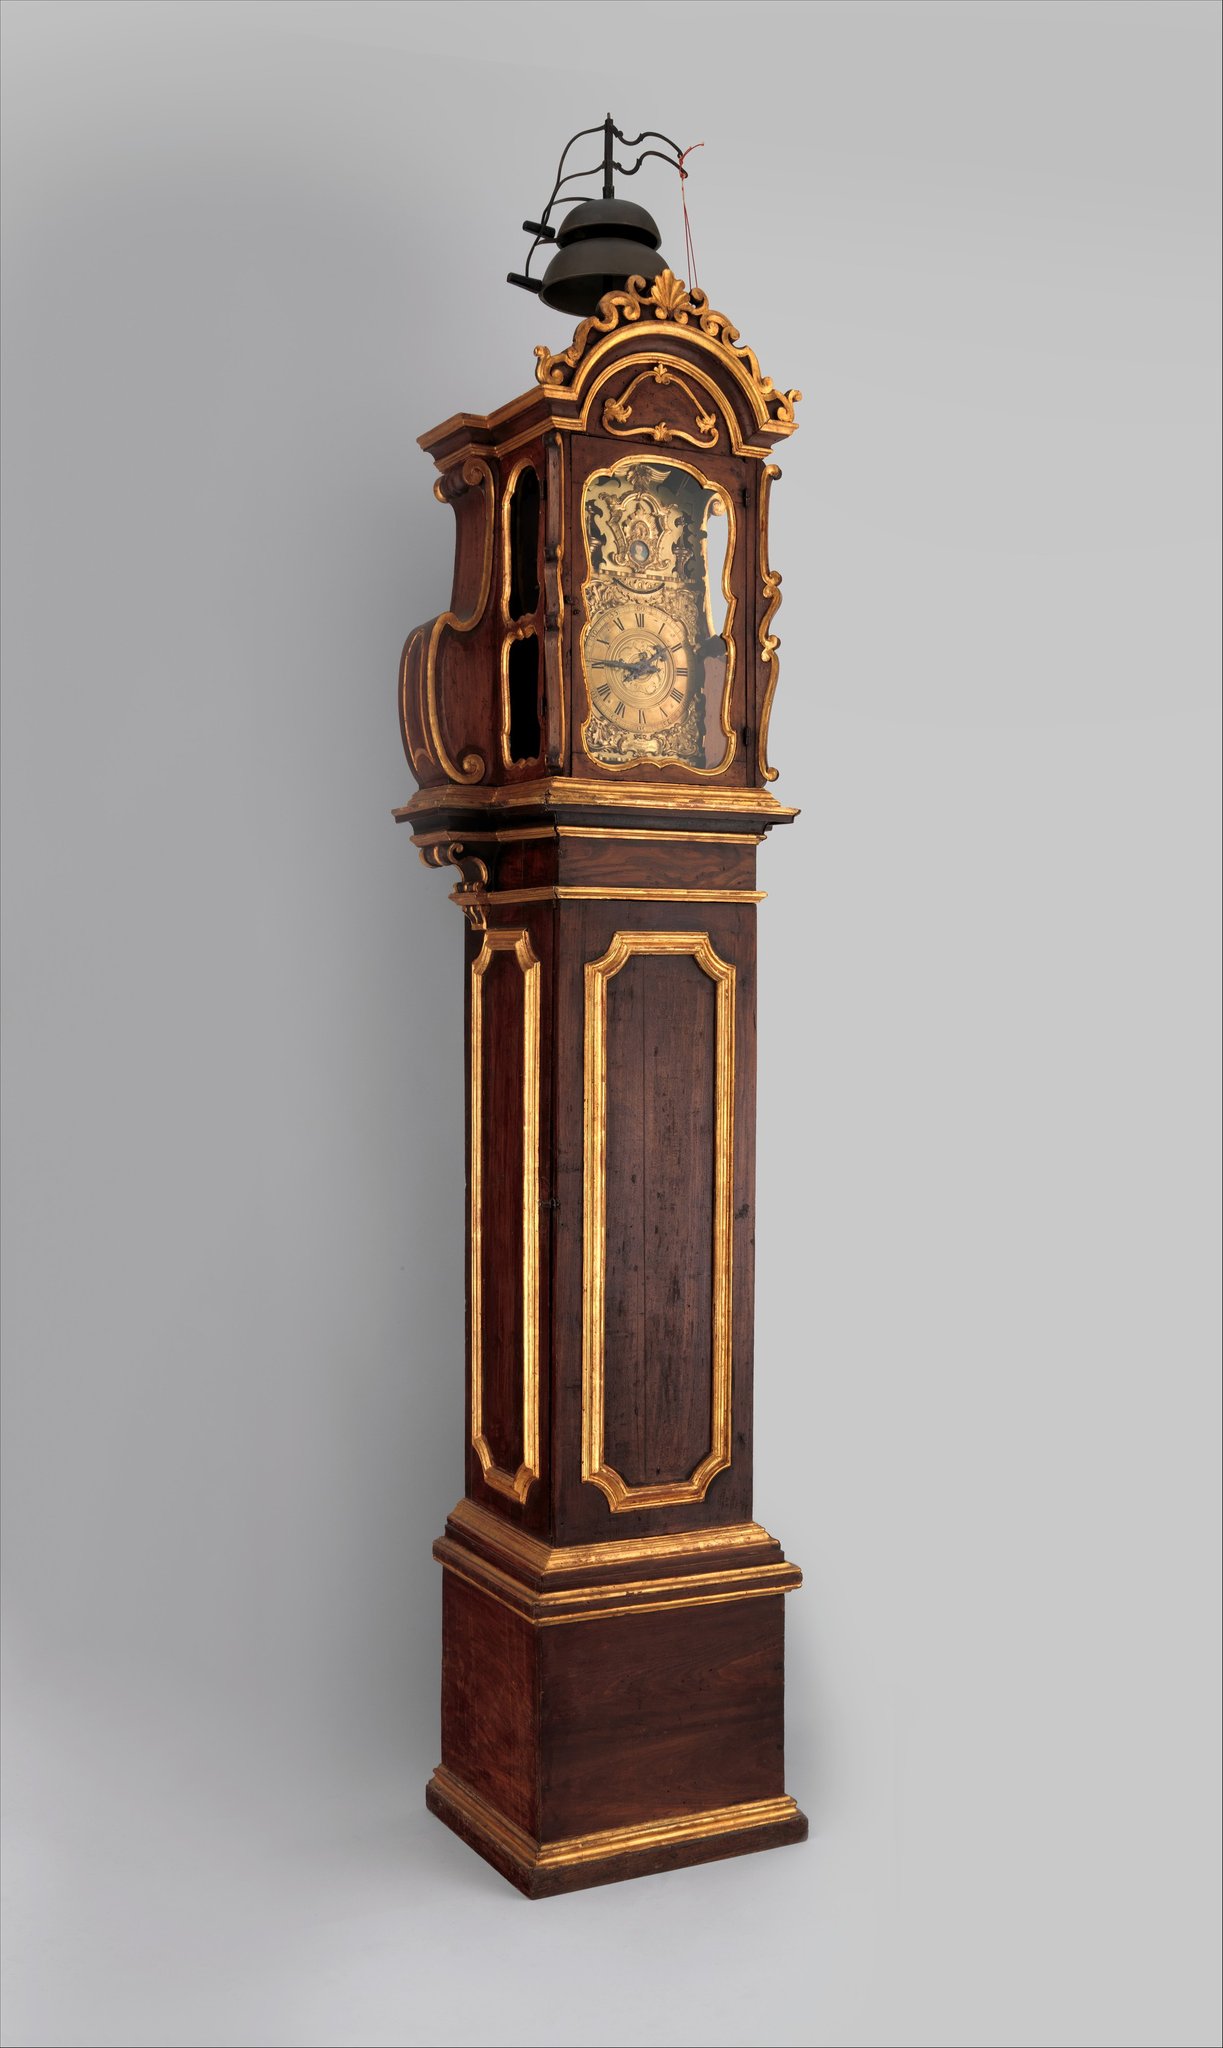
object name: longcase clock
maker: mario gambelli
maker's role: maker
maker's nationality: italian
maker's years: 1766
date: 1766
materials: brass, wood, steel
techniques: gilding